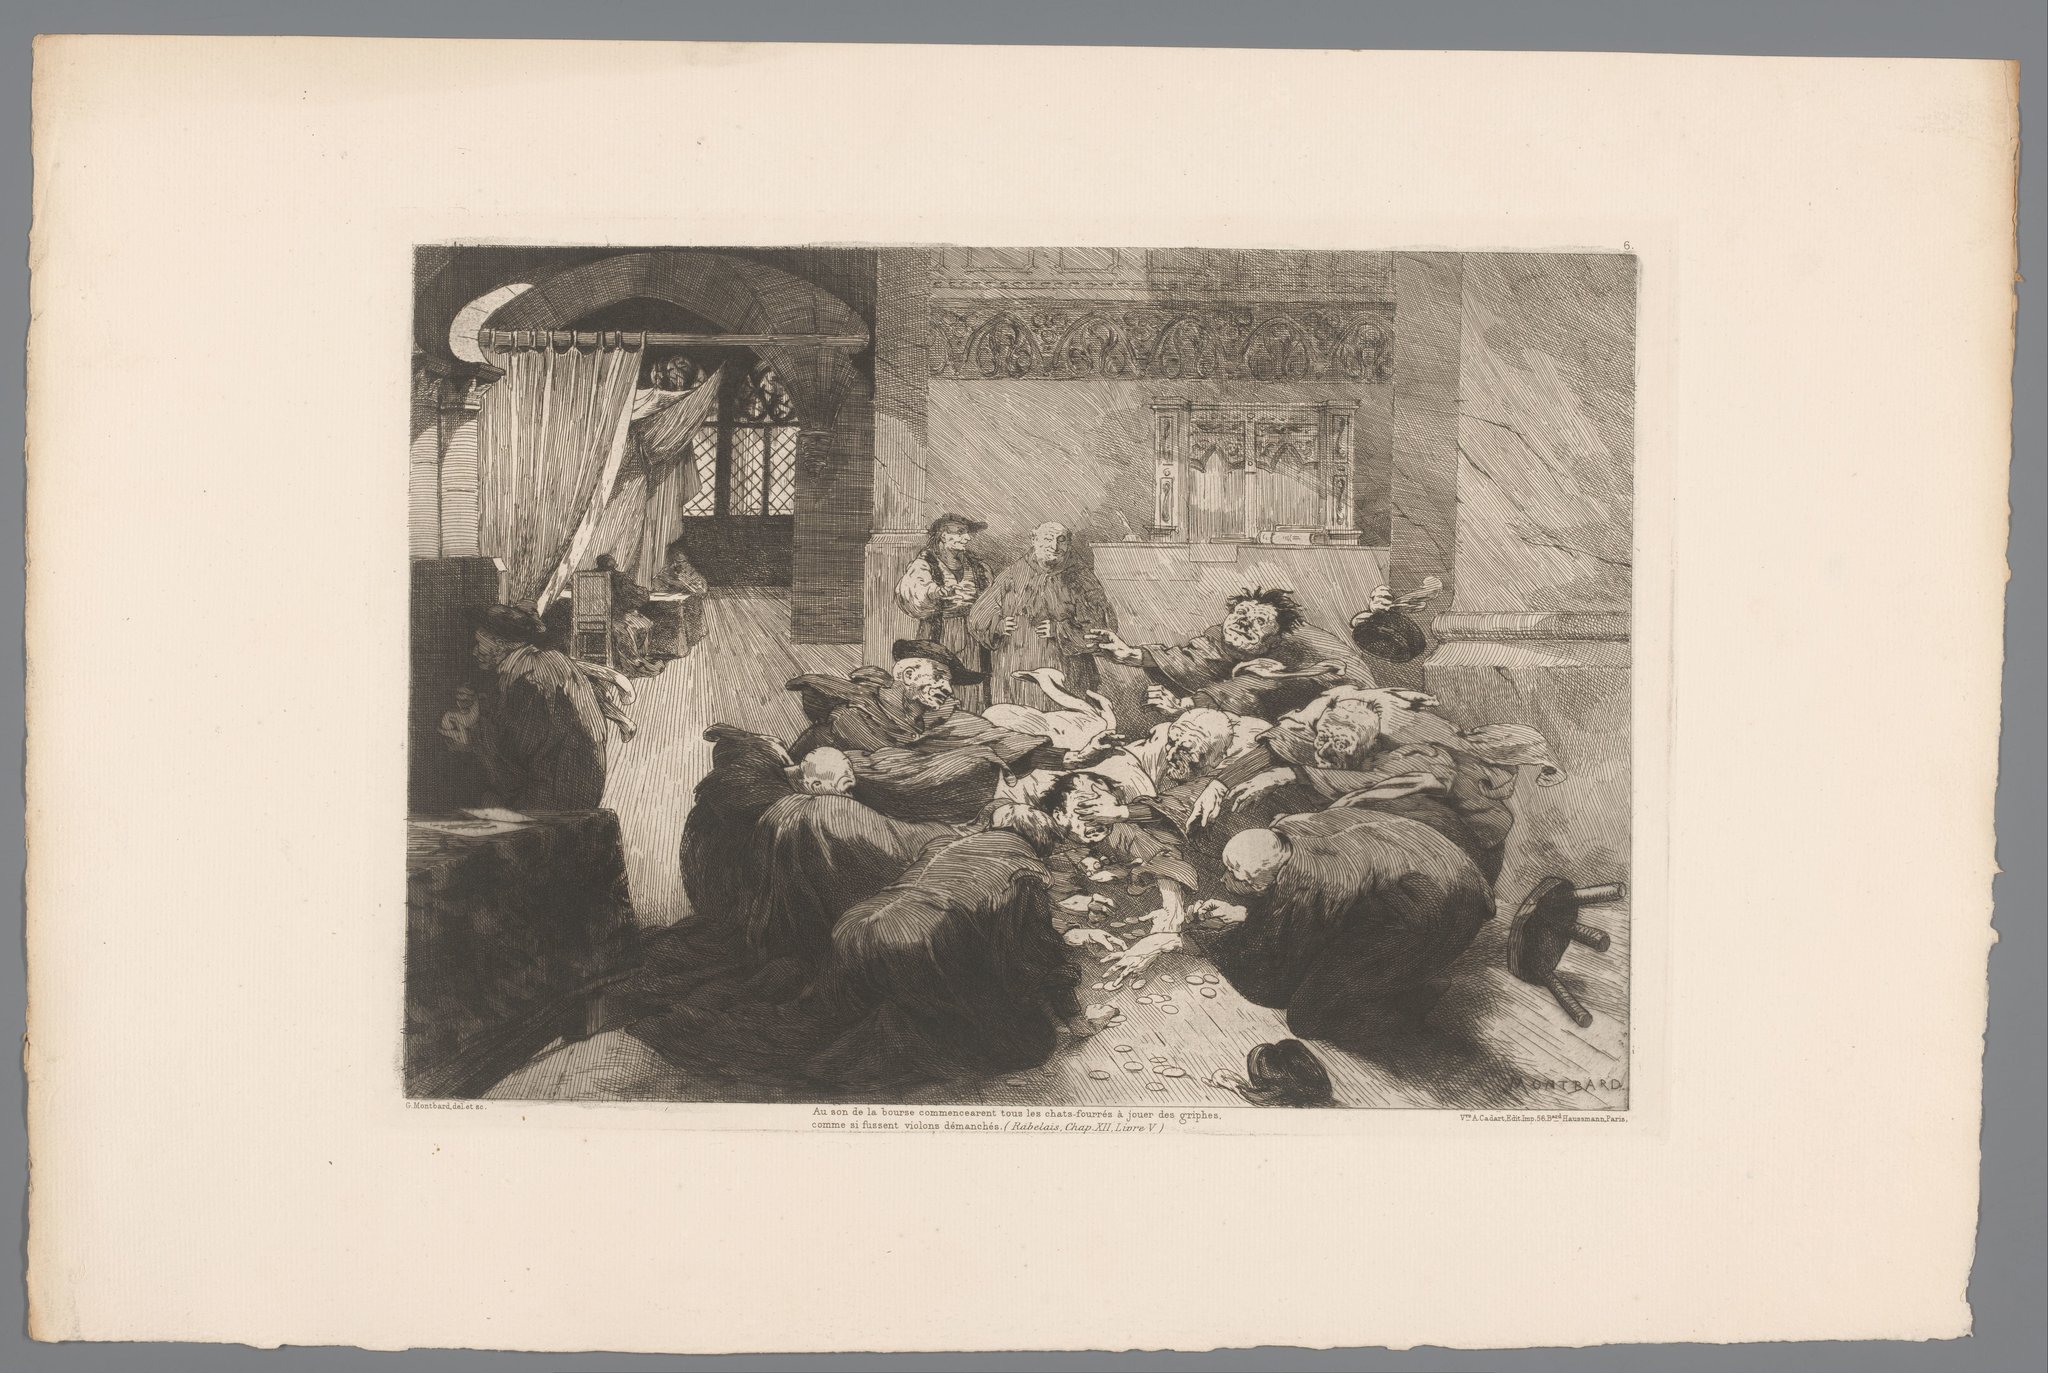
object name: print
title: Franse etsen uit 1877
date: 1877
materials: paper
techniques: drypoint, etching, intaglio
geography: paris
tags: greed, covetousness, cupidity; 'cupidità' (ripa), coin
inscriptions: collector's mark: Lugt 2228, collector's mark: ‘AFE v S’, collector's mark: Lugt 2760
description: Scène uit boek 5, hoofdstuk 13, van Gargantua en Pantagruel door Rabelais.